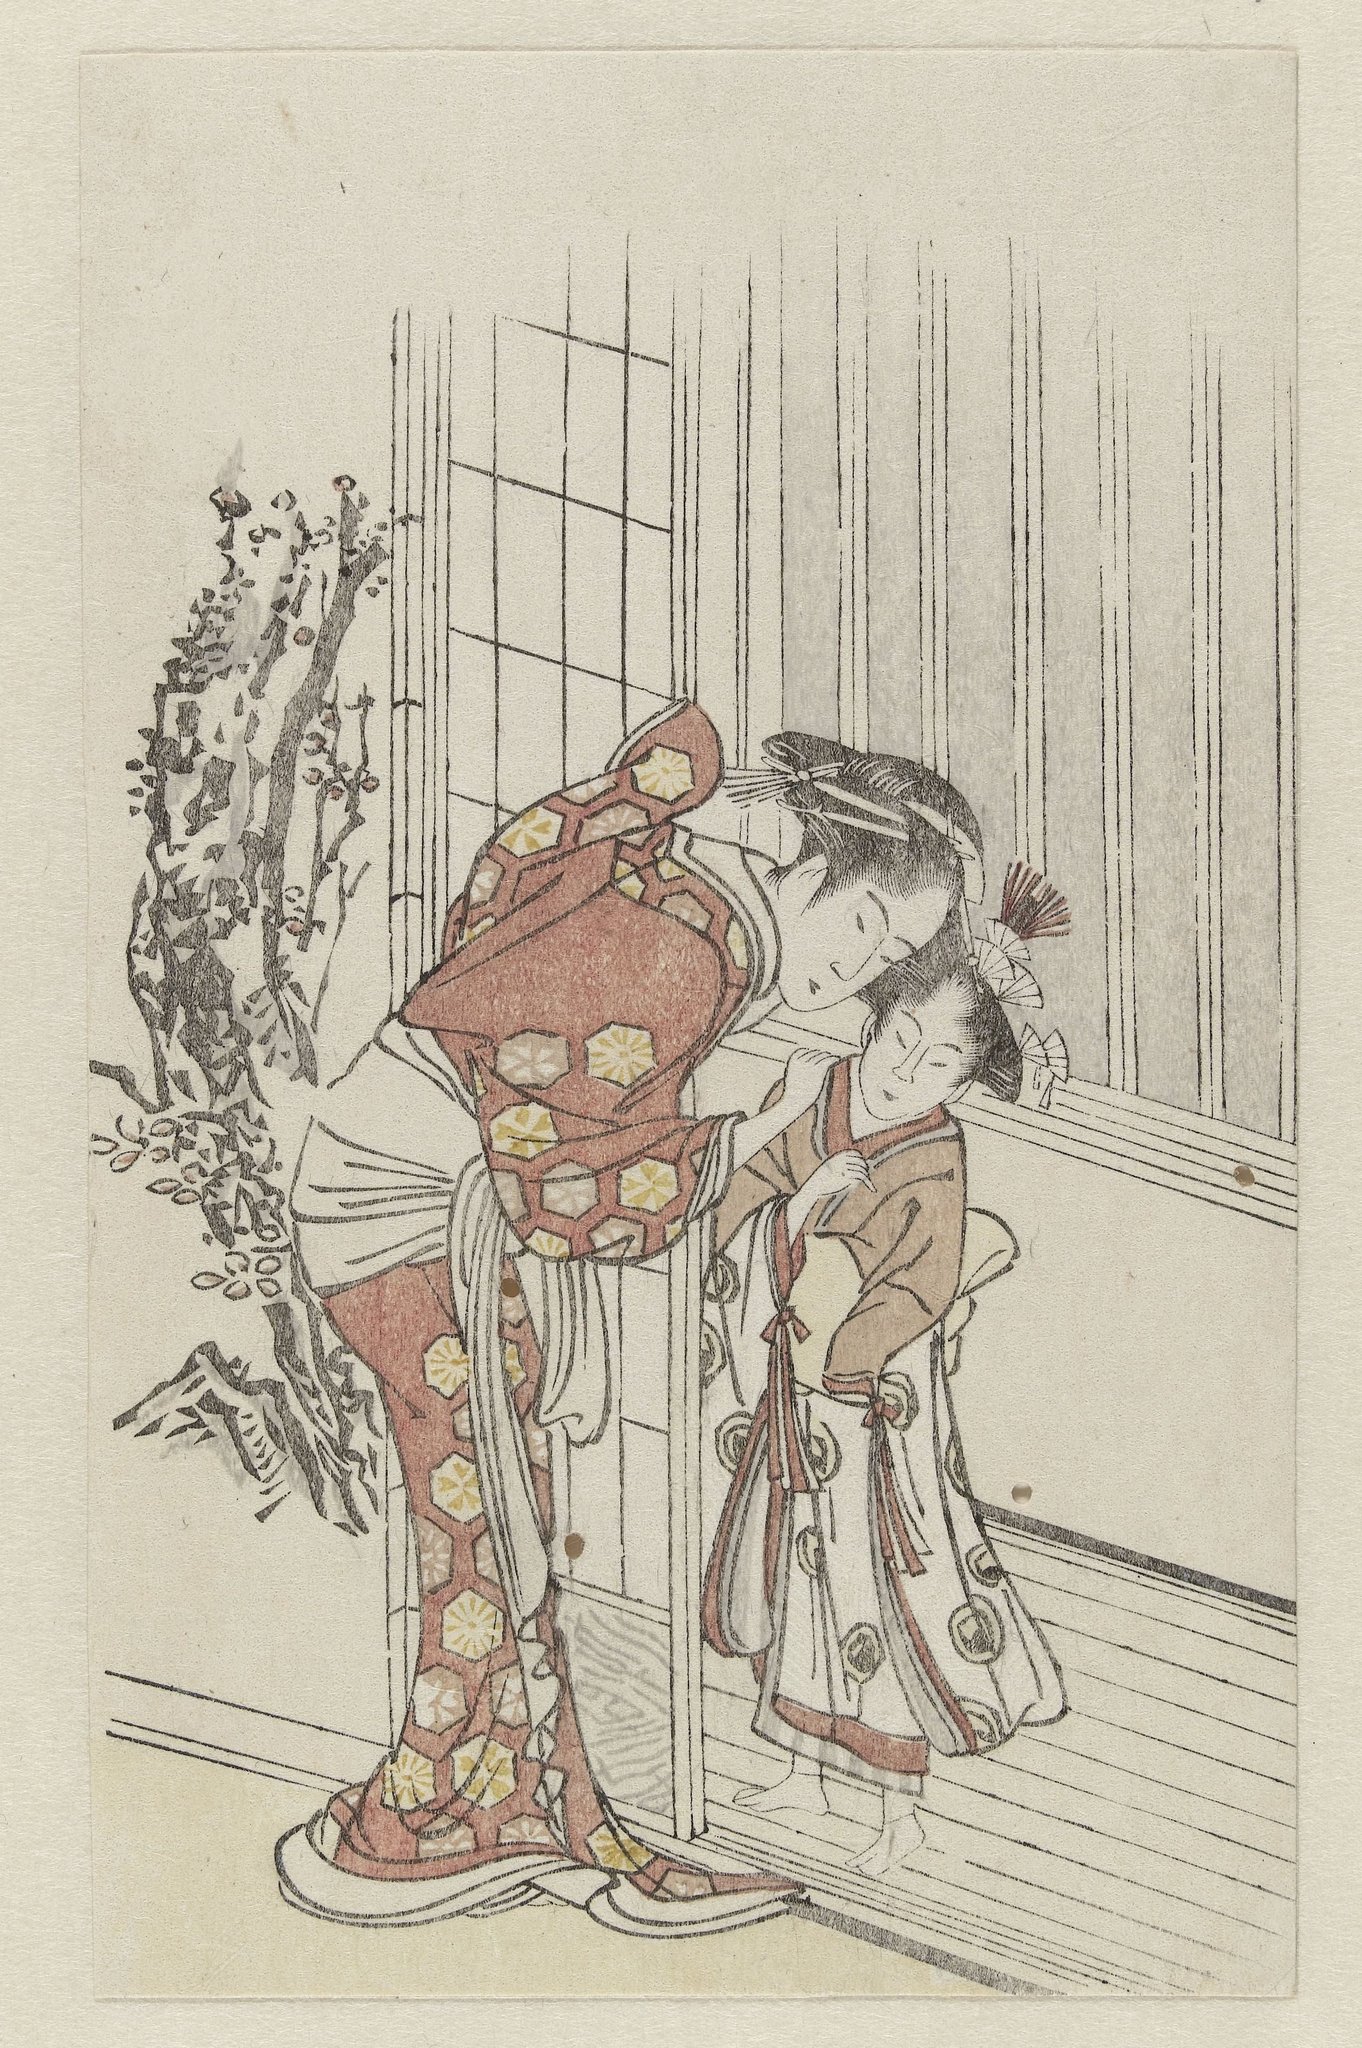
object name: print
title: Fluisterende vrouw en meisje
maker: Anonymous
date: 1797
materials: paper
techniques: blind stamped, woodcut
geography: japan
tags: speaking, balcony, mother and child(ren), woman and child(ren) (family group)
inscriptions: collector's mark, verso, stamped: Lugt 2228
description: Een courtisane staat in een kamer en fluistert iets in het oor van het meisje op de veranda. De korte maanden voor het nieuwe jaar zijn aangegeven in het nervenpatroon van het hout aan de onderkant van de schuifdeur.